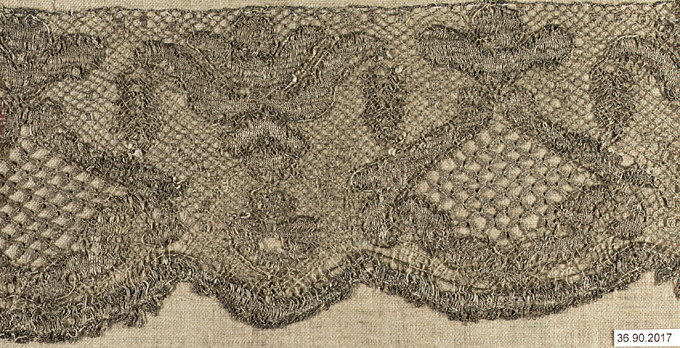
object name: piece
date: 1701-1800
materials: metal thread, silk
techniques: lace